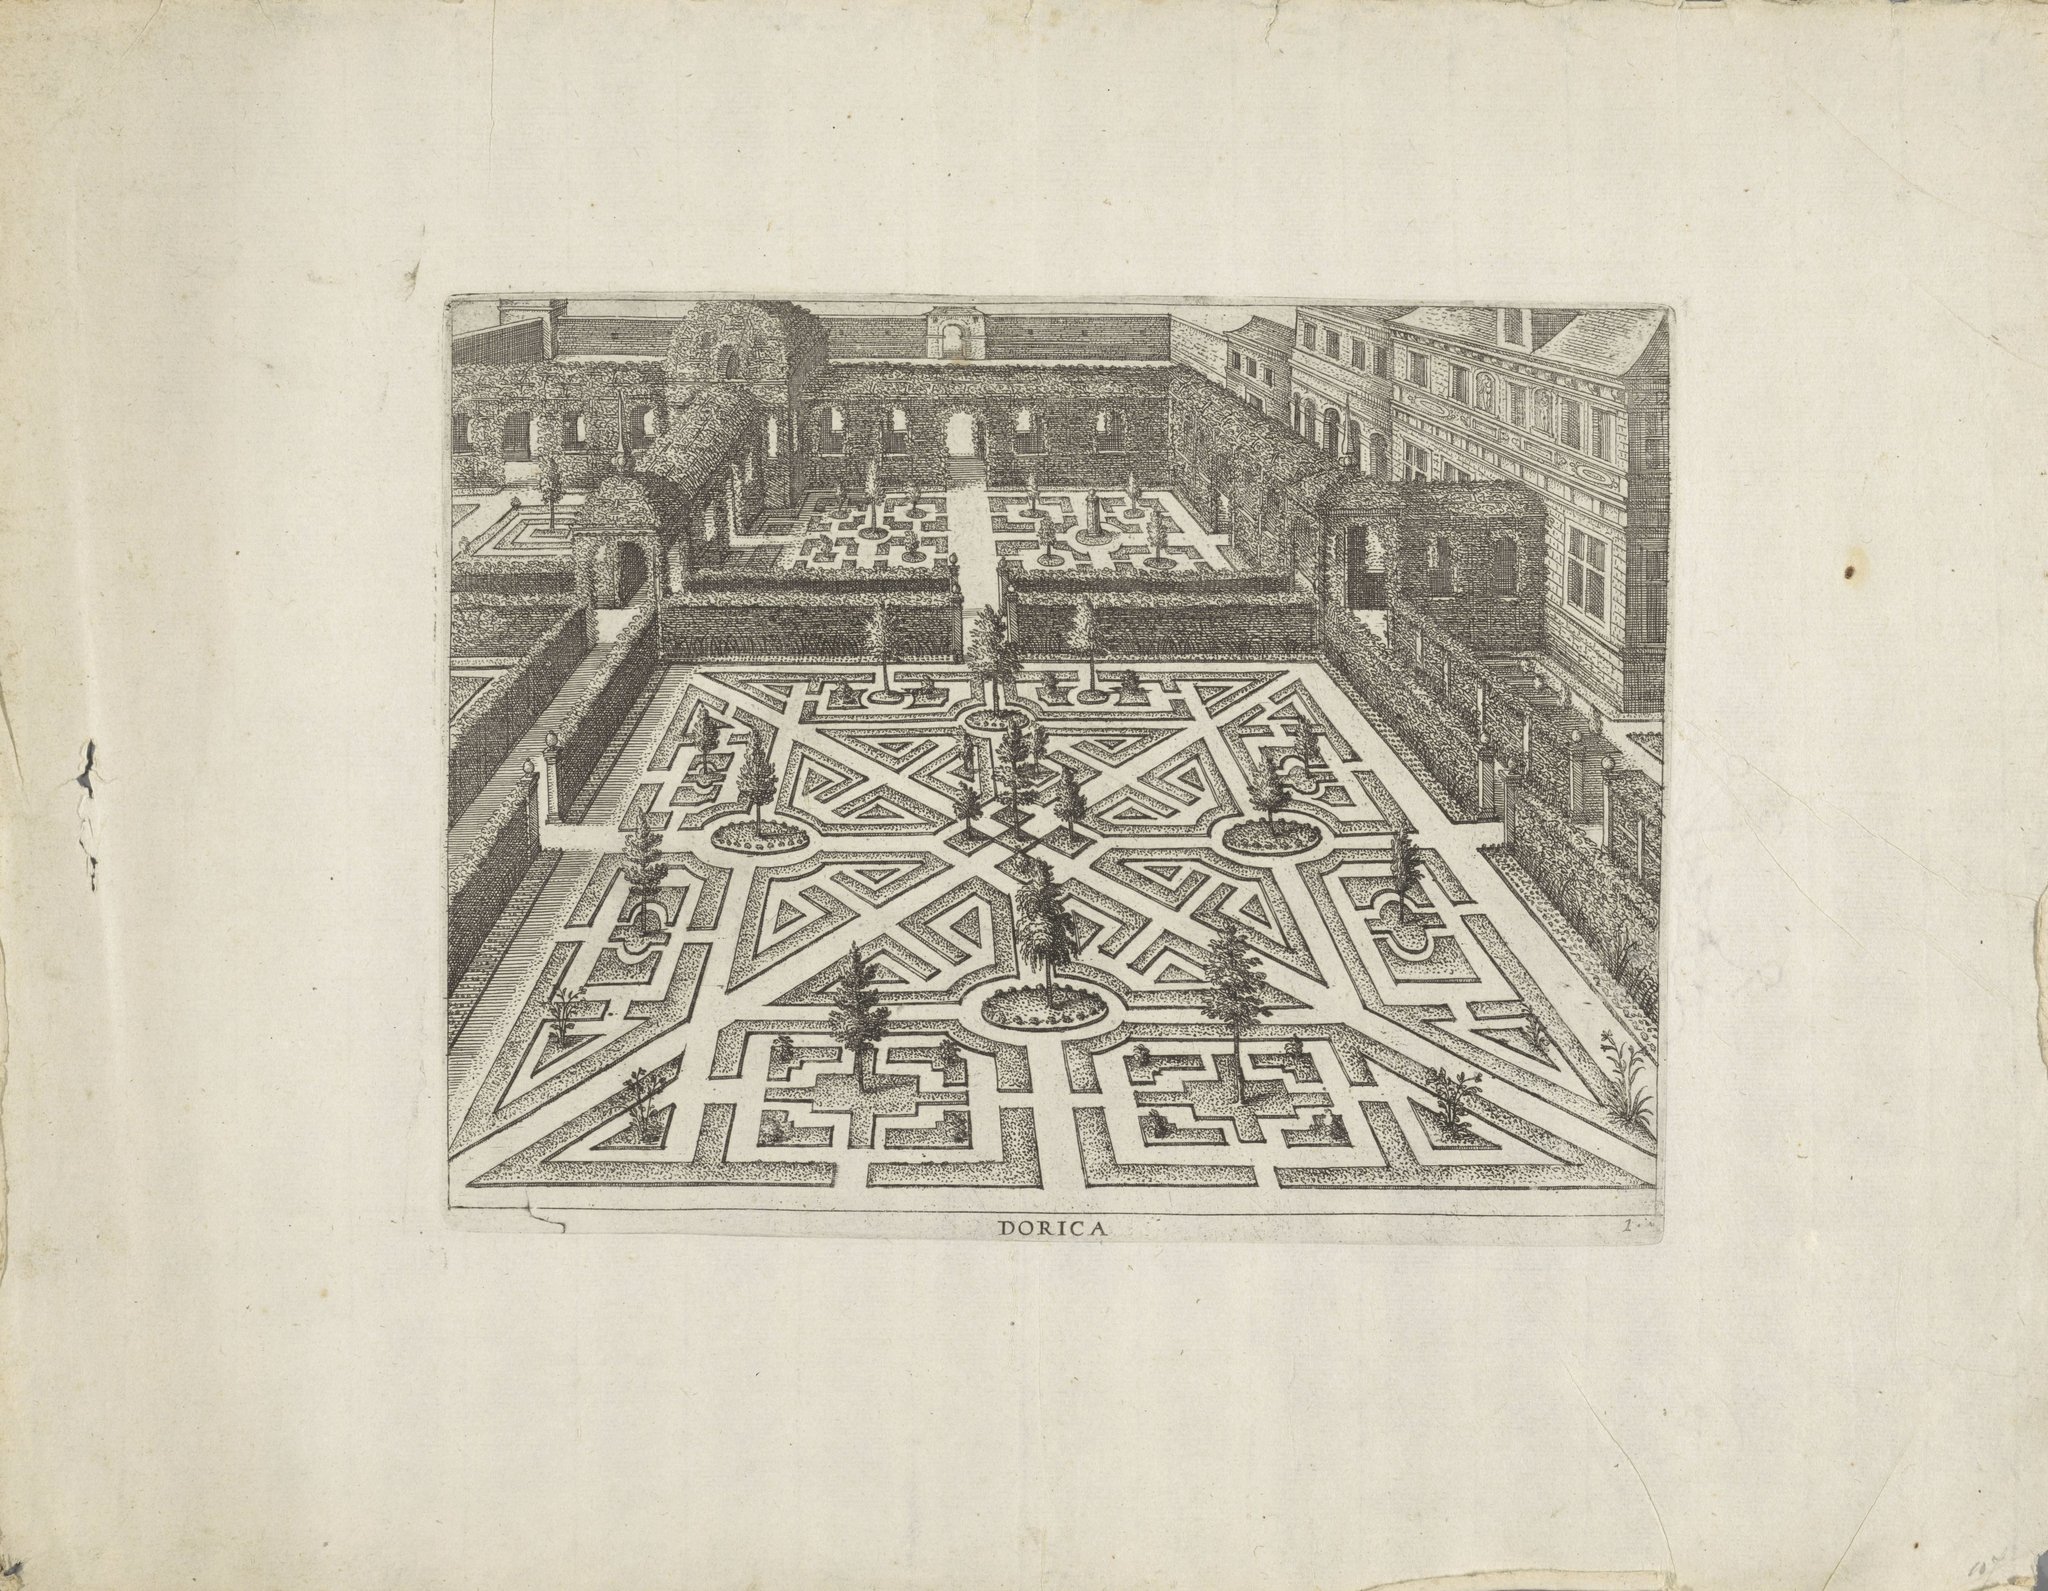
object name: print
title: Hortorum Viridariorumque (...)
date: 1583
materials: paper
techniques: etching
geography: antwerp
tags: garden, french or architectonic garden; formal garden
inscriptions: collector's mark: Lugt 2228, collector's mark: Lugt 2760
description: De serie ‘Hortorum Viridariorumque’ van Vredeman de Vries (Hollstein Dutch 470-490) is in deze editie van de serie door uitgever Joannes Galle ( en eerder door zijn voorganger Theodoor Galle) aangevuld met de serie ‘Tuinen’ van Vredeman de Vries (Hollstein Dutch 508-515) en met twee prenten van Pieter van der Borcht (I) (New Hollstein Dutch 161-162). De prenten zijn genummerd: 1-30. Origineel hoort bij deze editie van de serie, uitgegeven door Joannes Galle, nog een prent van Van der Borcht met nummer 31, maar deze prent ontbreekt in deze serie in de collectie van het Rijksmuseum.